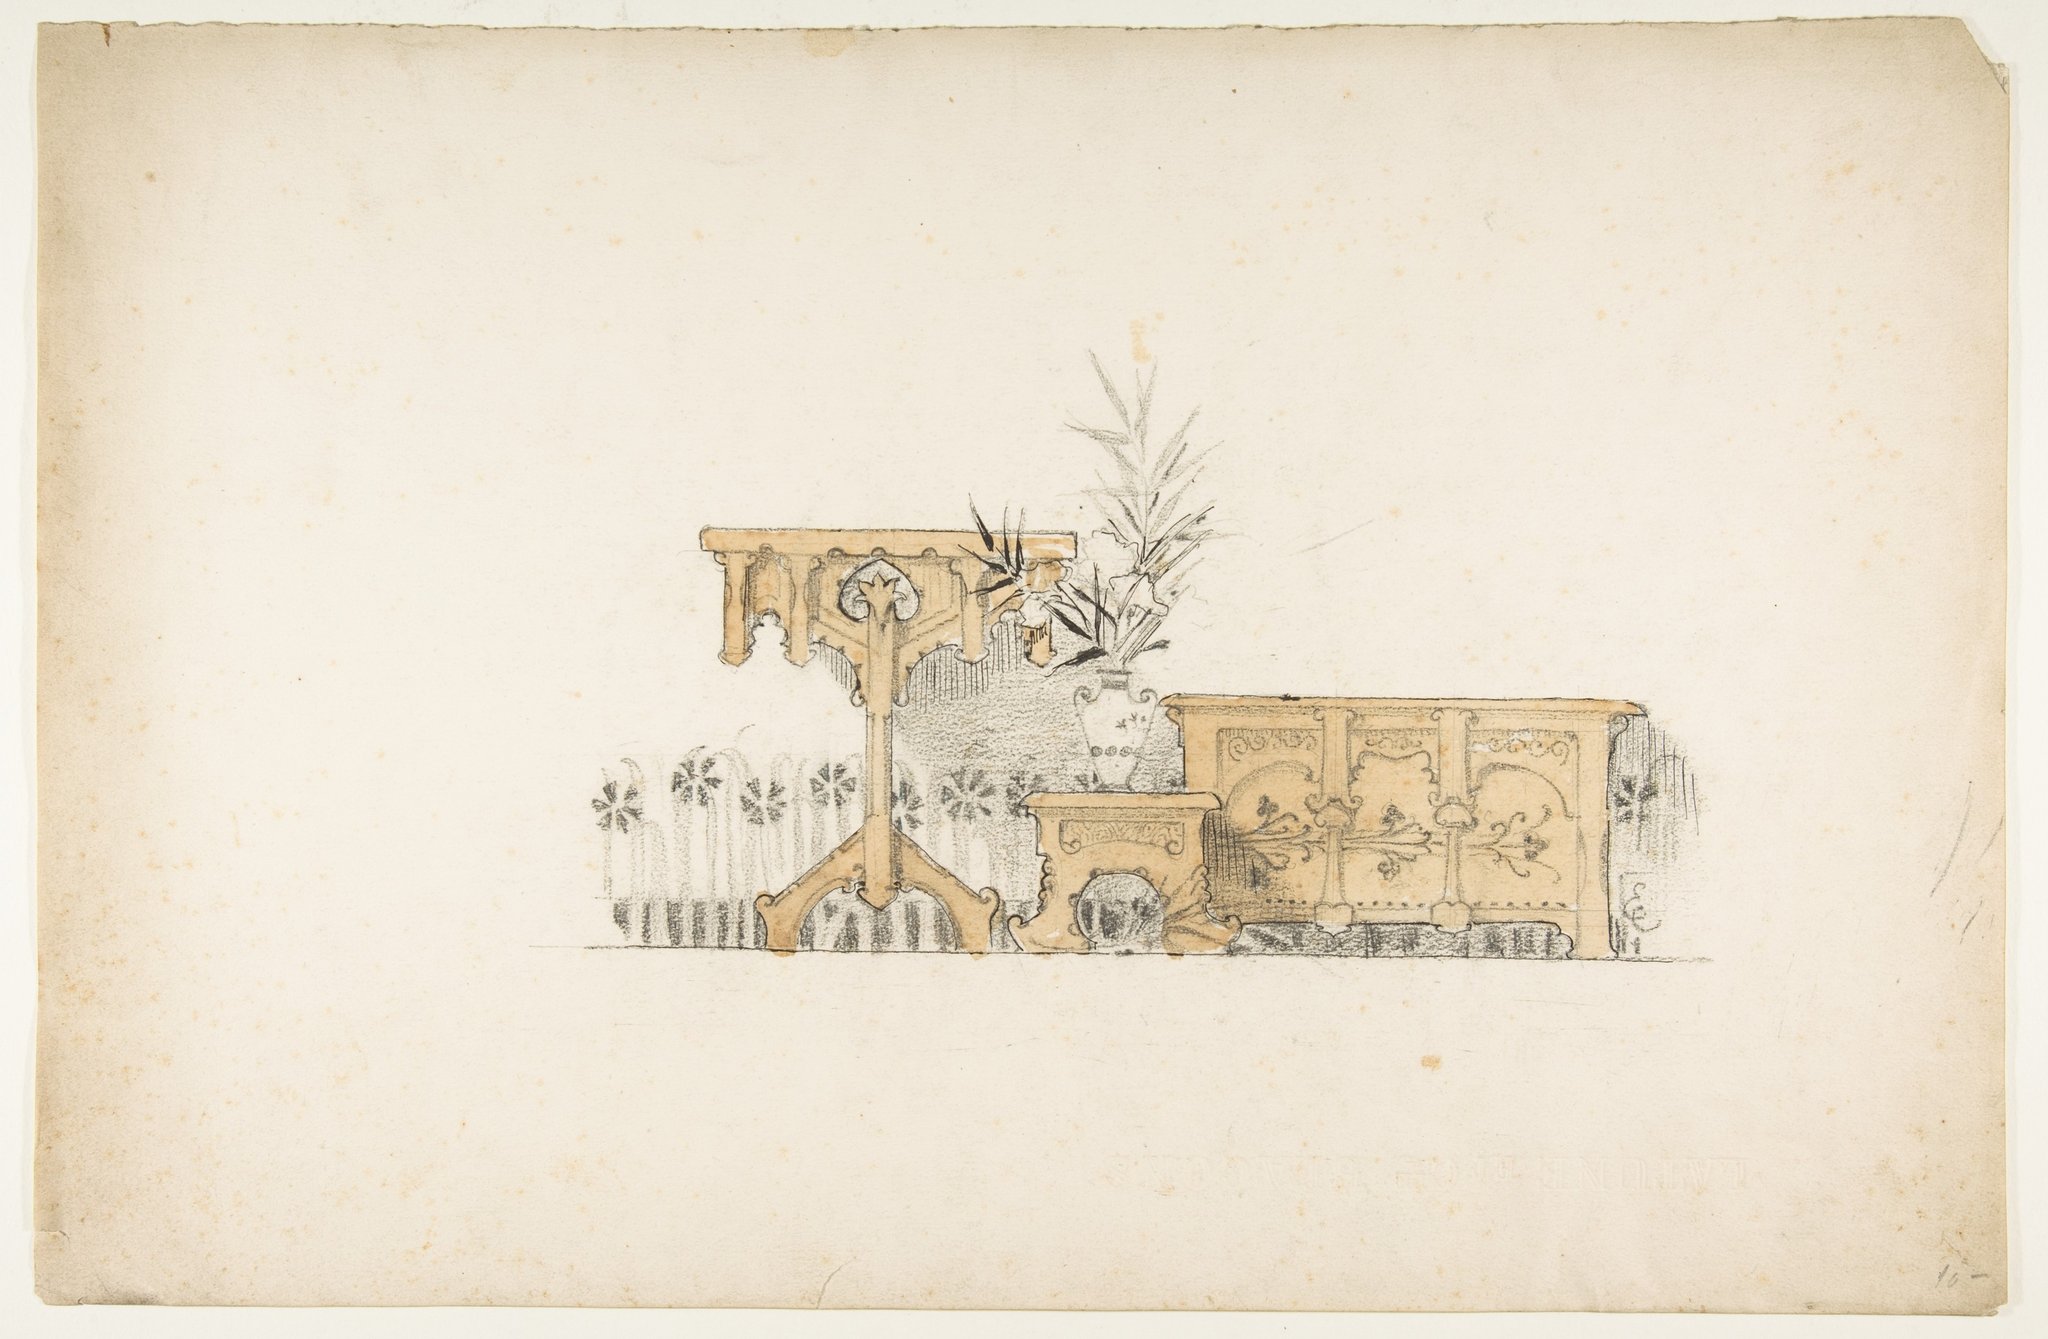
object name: drawing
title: Design for a Buffet, Plant Stand, and Table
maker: anonymous, french, 19th century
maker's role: artist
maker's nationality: french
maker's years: 1800-1900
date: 1801-1900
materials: chalk, ink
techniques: brush, pen, wash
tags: furniture,tables